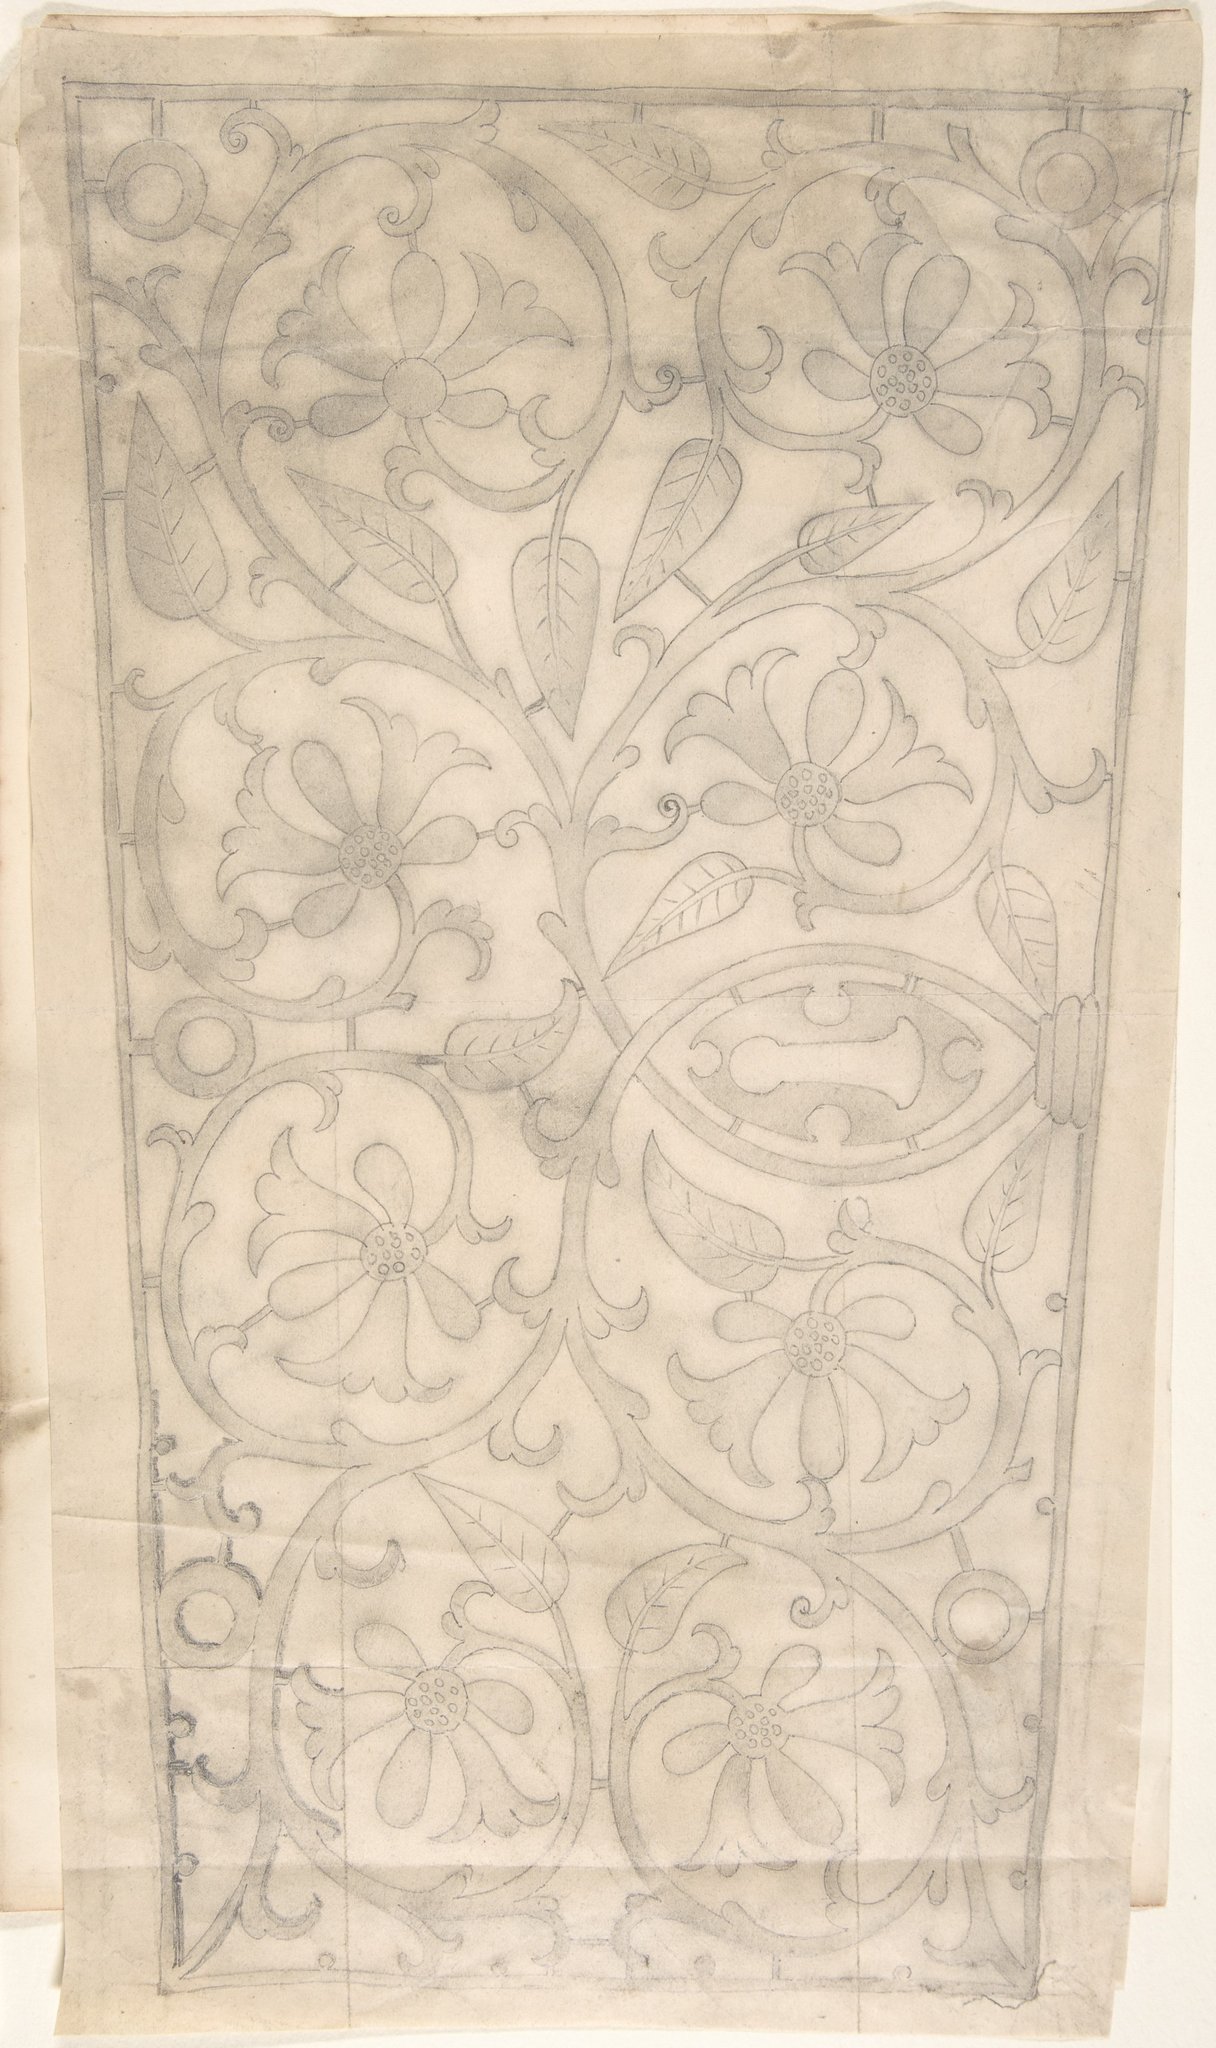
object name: drawing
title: Floral and Foliate Ornamented Metal Keyplate Design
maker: anonymous, british, 19th century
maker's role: artist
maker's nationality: british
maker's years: 1800-1900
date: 1851-1900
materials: graphite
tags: ornament,leaves